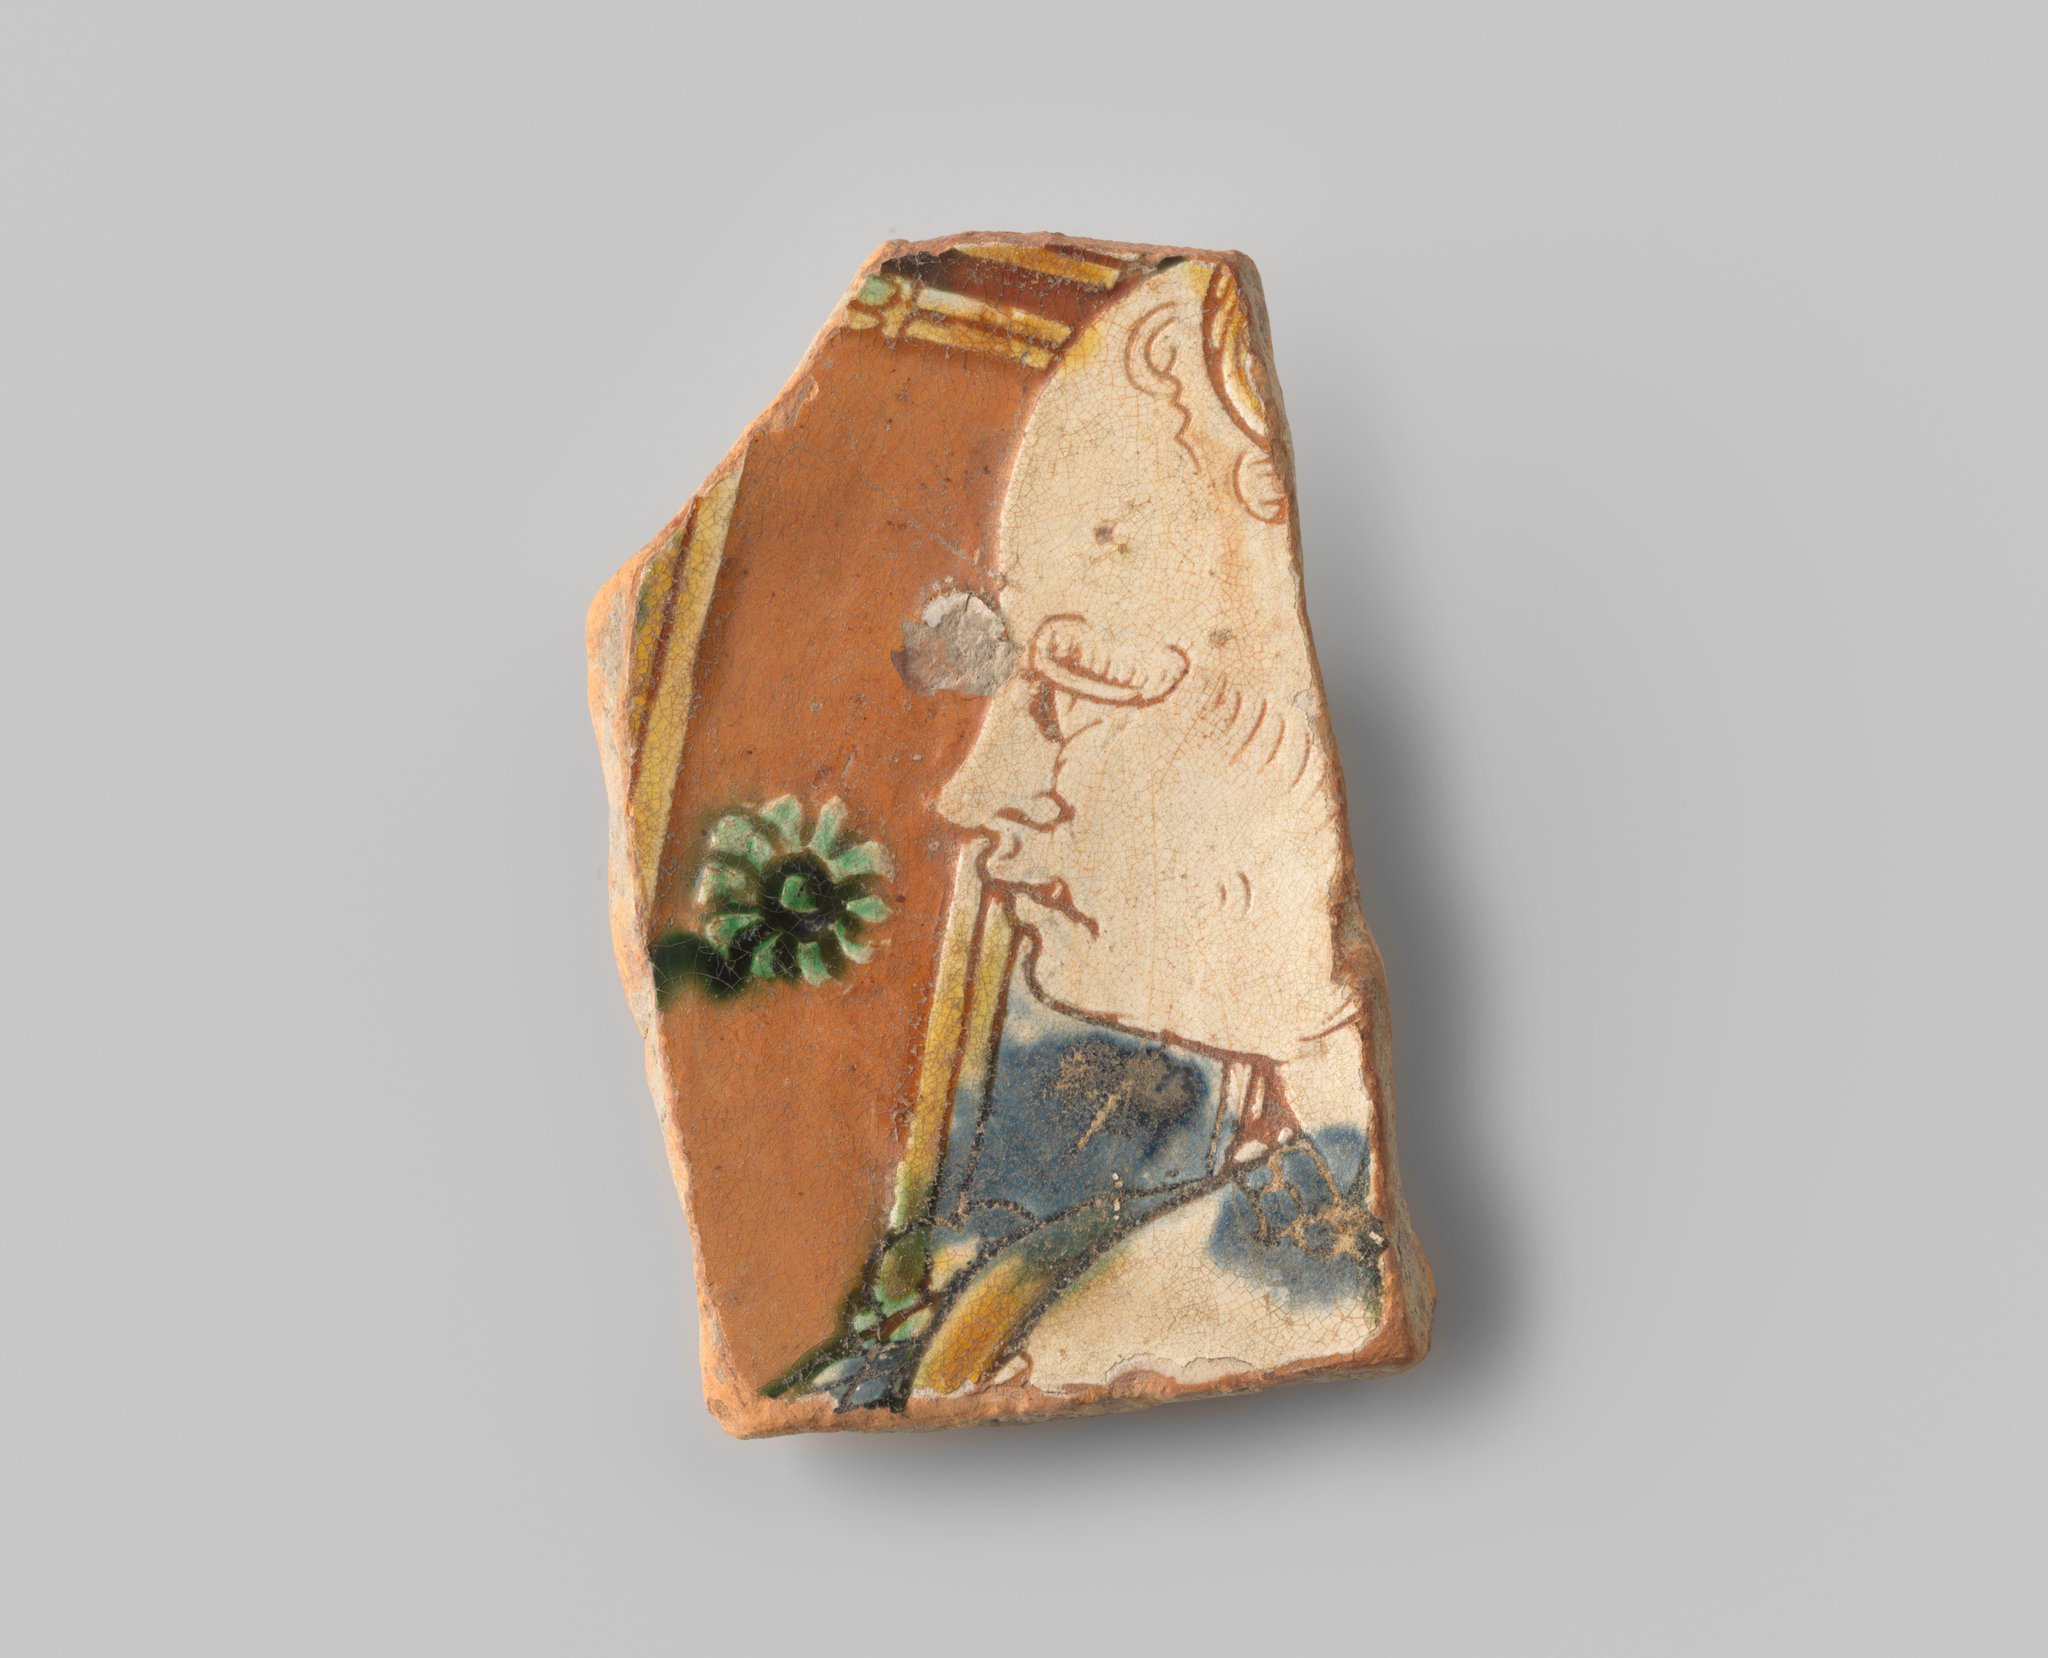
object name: sherd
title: Fragment (voet) van een grote schaal met rode scherf, in sgraffito-techniek een naar links gewend vrouwenborstbeeld, als achtergrond door okerkleurige lijsten ingesloten panelen, in blauw, oranje, bruin, waarop een groene bloem; op de onderzijde is aan de basis een rode punt vrijgelaten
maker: Anonymous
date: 1200-1899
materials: earthenware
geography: italy